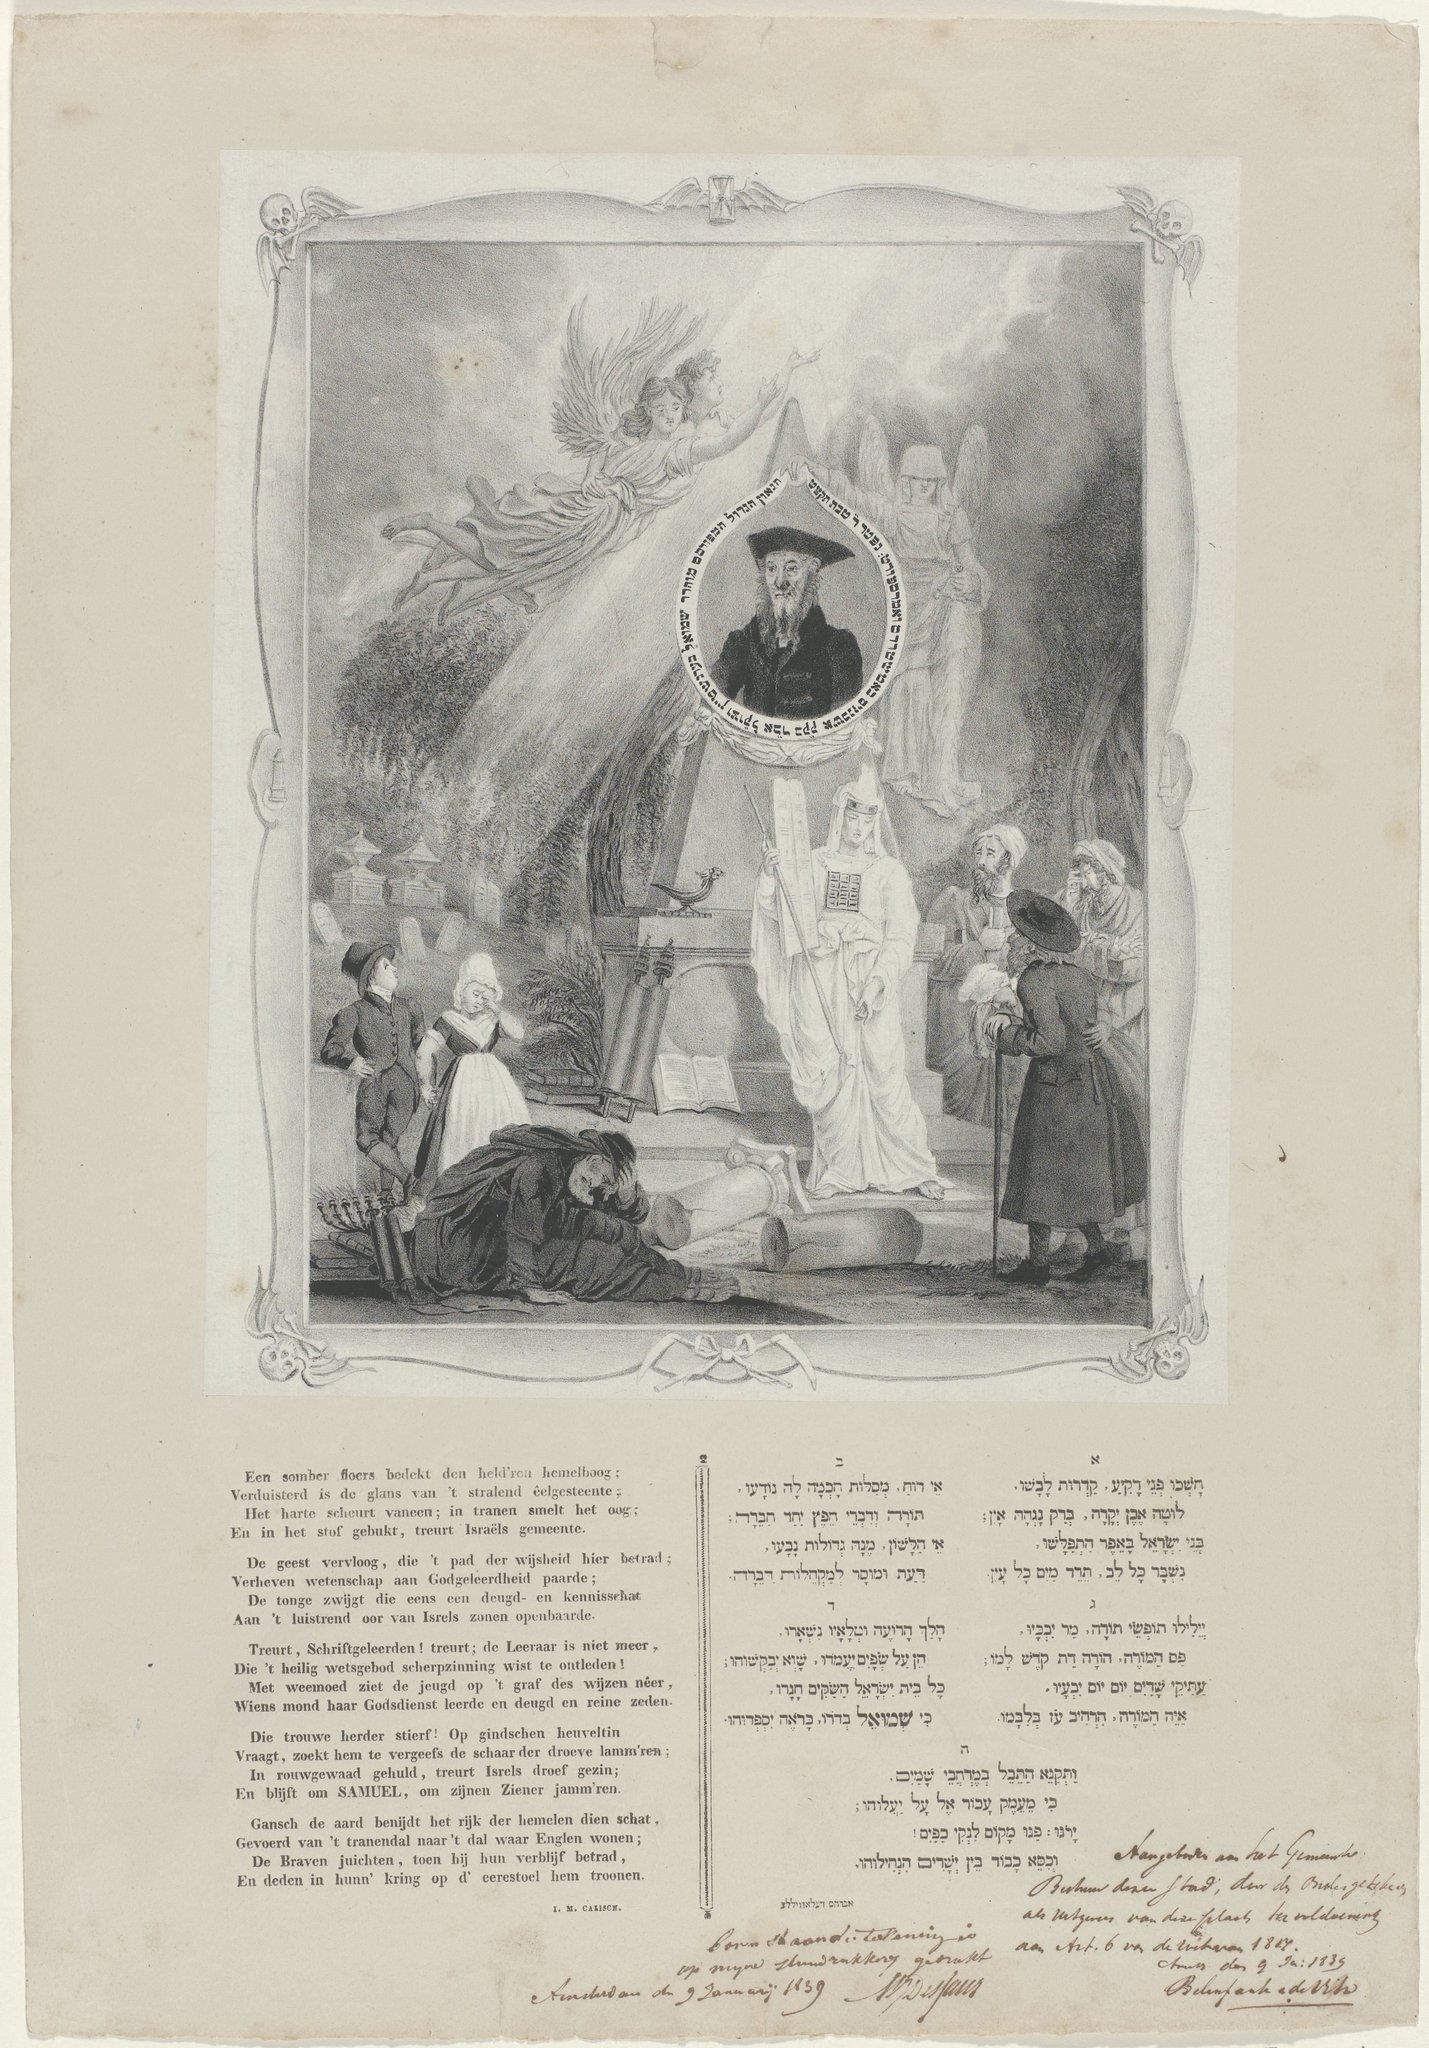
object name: print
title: Rouwprent bij het overlijden van rabbijn Samuel Berenstein, 1838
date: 1838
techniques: printmaking, letterpress printing, lithograph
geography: amsterdam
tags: amsterdam, 'synagoga', synagogue, i.e. jewish religion personified (or symbolized), churchyard, cemetery, grave-building, monumental tomb, death and burial ~ jewish customs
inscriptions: collector's mark: Lugt 2228, : ‘bovenstaande tekening is op mijne steendrukkerij gedrukt Amsterdam den 9 Januarij 1839 M. Dessauer / Aangeboden aan het Gemeente Bestuur dezen stad, door de onder getekende als uitgever van deze plaat ter voldoening aan Art. 6 van de wet van 1817. Ams. den 9 Ja: 1839 Belinfante & de Vita.’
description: Rouwprent bij het overlijden van Amsterdamse rabbijn Samuel Berisch Berenstein, 21 december 1838. Allegorisch grafmonument waarop een portret van de rabbijn. In de wolken enkele engelen. Voor het graf een personificatie van het Joodse (Synagoga) geloof met de wetstafelen, links op de grond een rouwende schriftgeleerde. Met twee verzen in het Nederlands en Hebreews.